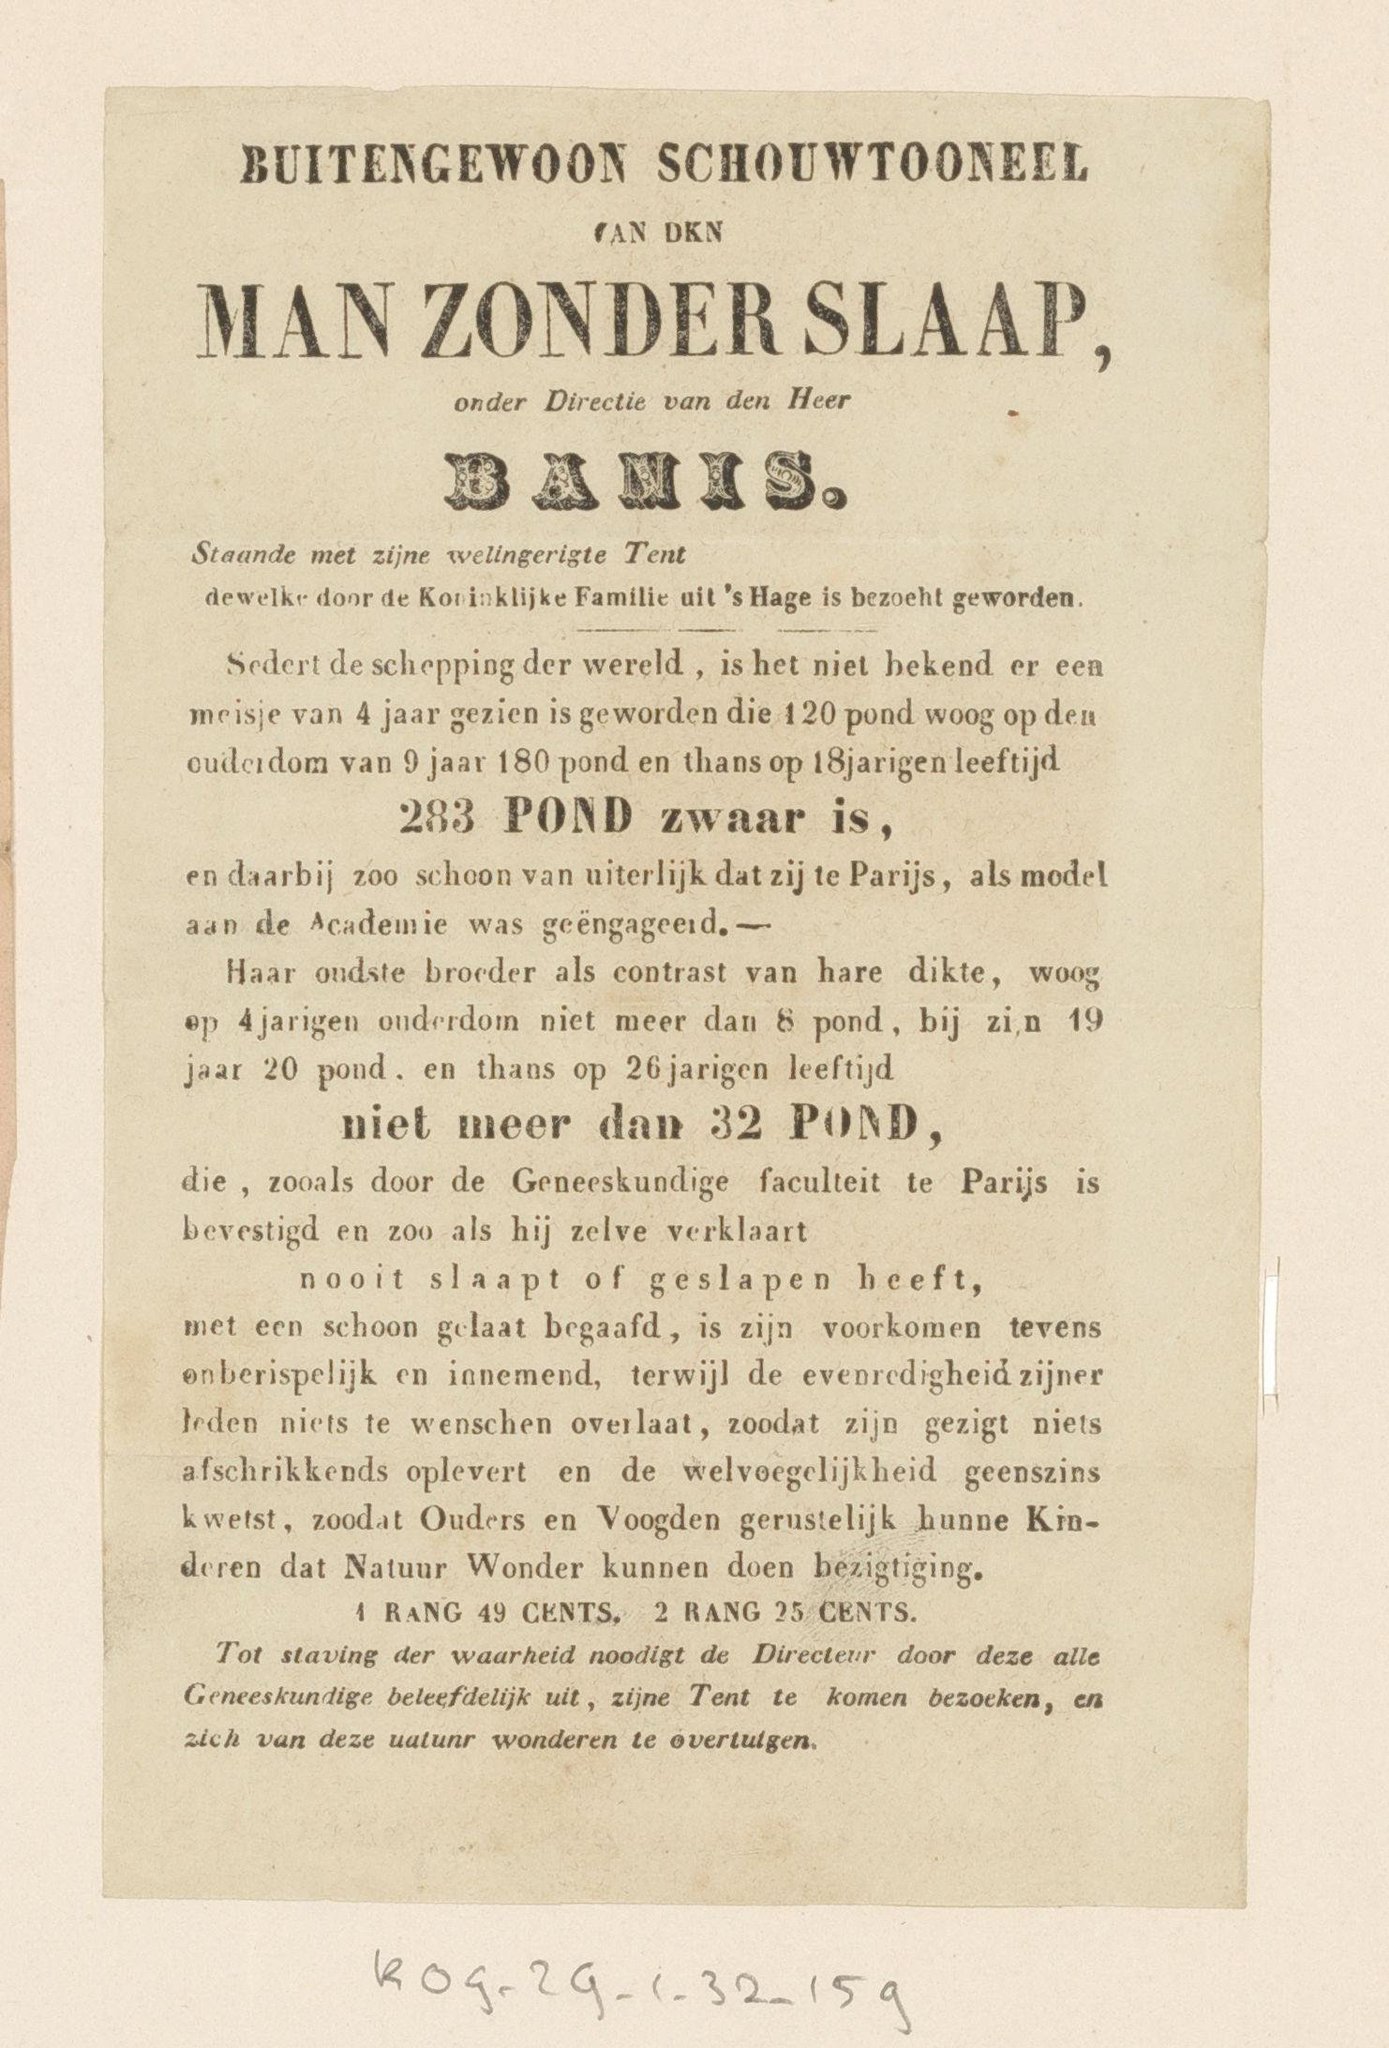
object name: reclamebiljet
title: Buitengewoon schouwtooneel van den Man zonder Slaap, onder directie van den heer Banis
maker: Anonymous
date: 1857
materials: paper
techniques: letterpress printing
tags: human beings (legendary or not) of abnormal proportions, size, strength, etc. - aa - female human figure, human beings (legendary or not) of abnormal proportions, size, strength, etc., pleasure fair and circus, human monstrosities ~ freak show, sleeping; unconsciousness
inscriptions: collector's mark, collector's mark: Lugt 1641